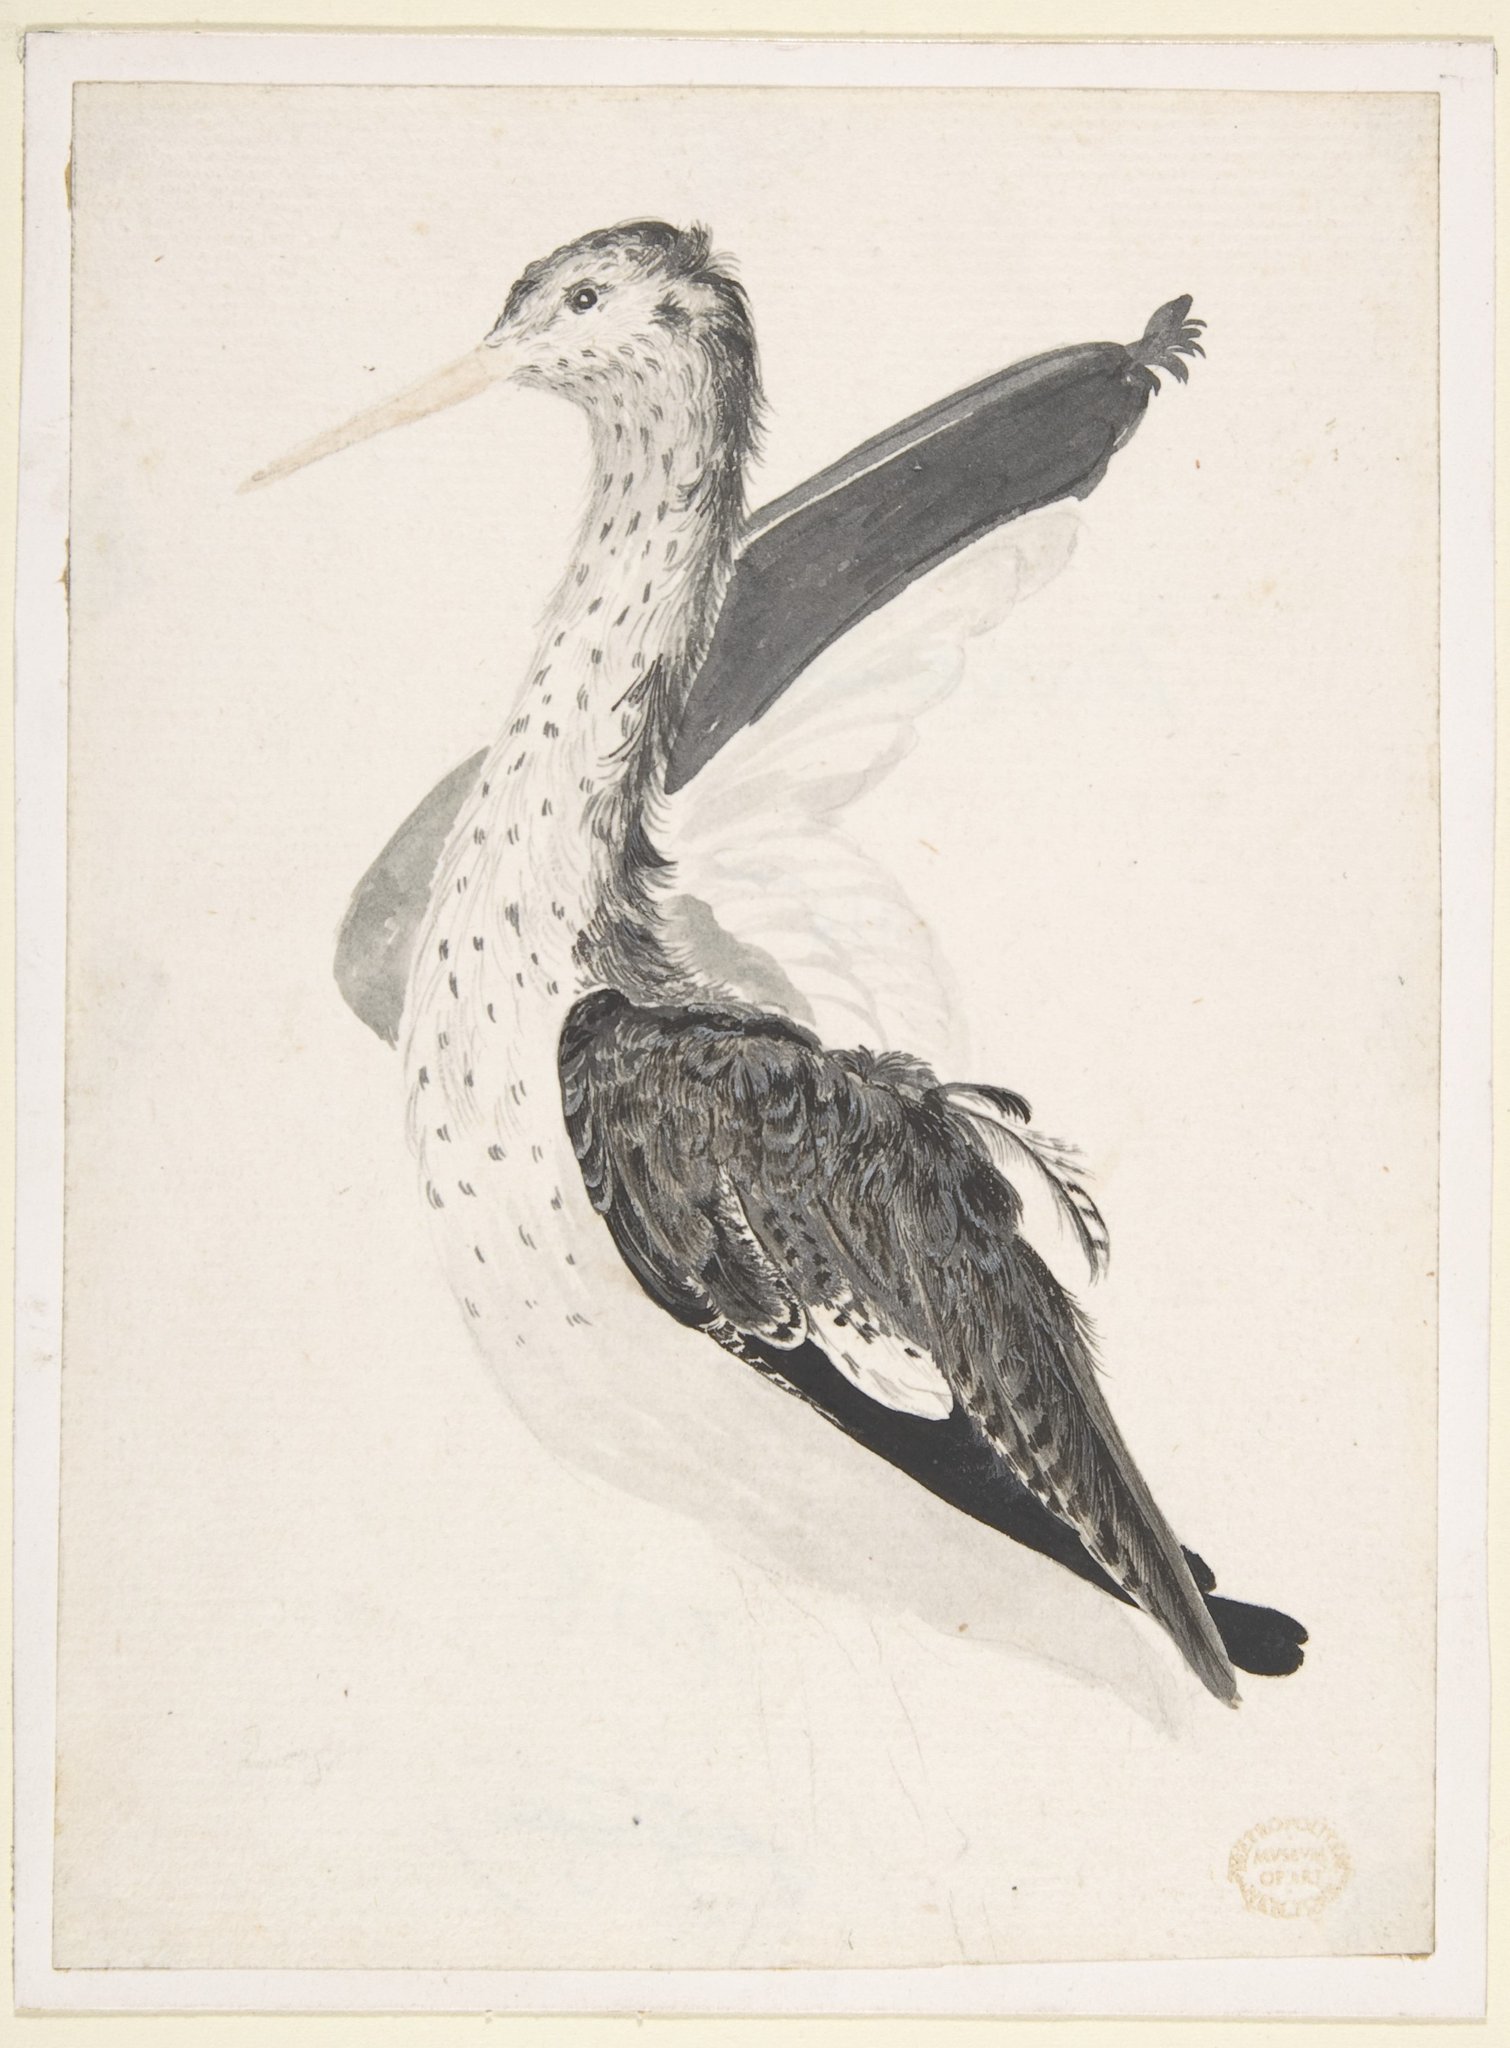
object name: drawing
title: Bird, Perhaps an Egret, Seen in Profile with One Wing Lifted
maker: count giorgio durante (duranti)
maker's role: artist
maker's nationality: italian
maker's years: 1685-1755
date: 1685-1755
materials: graphite, watercolor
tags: birds